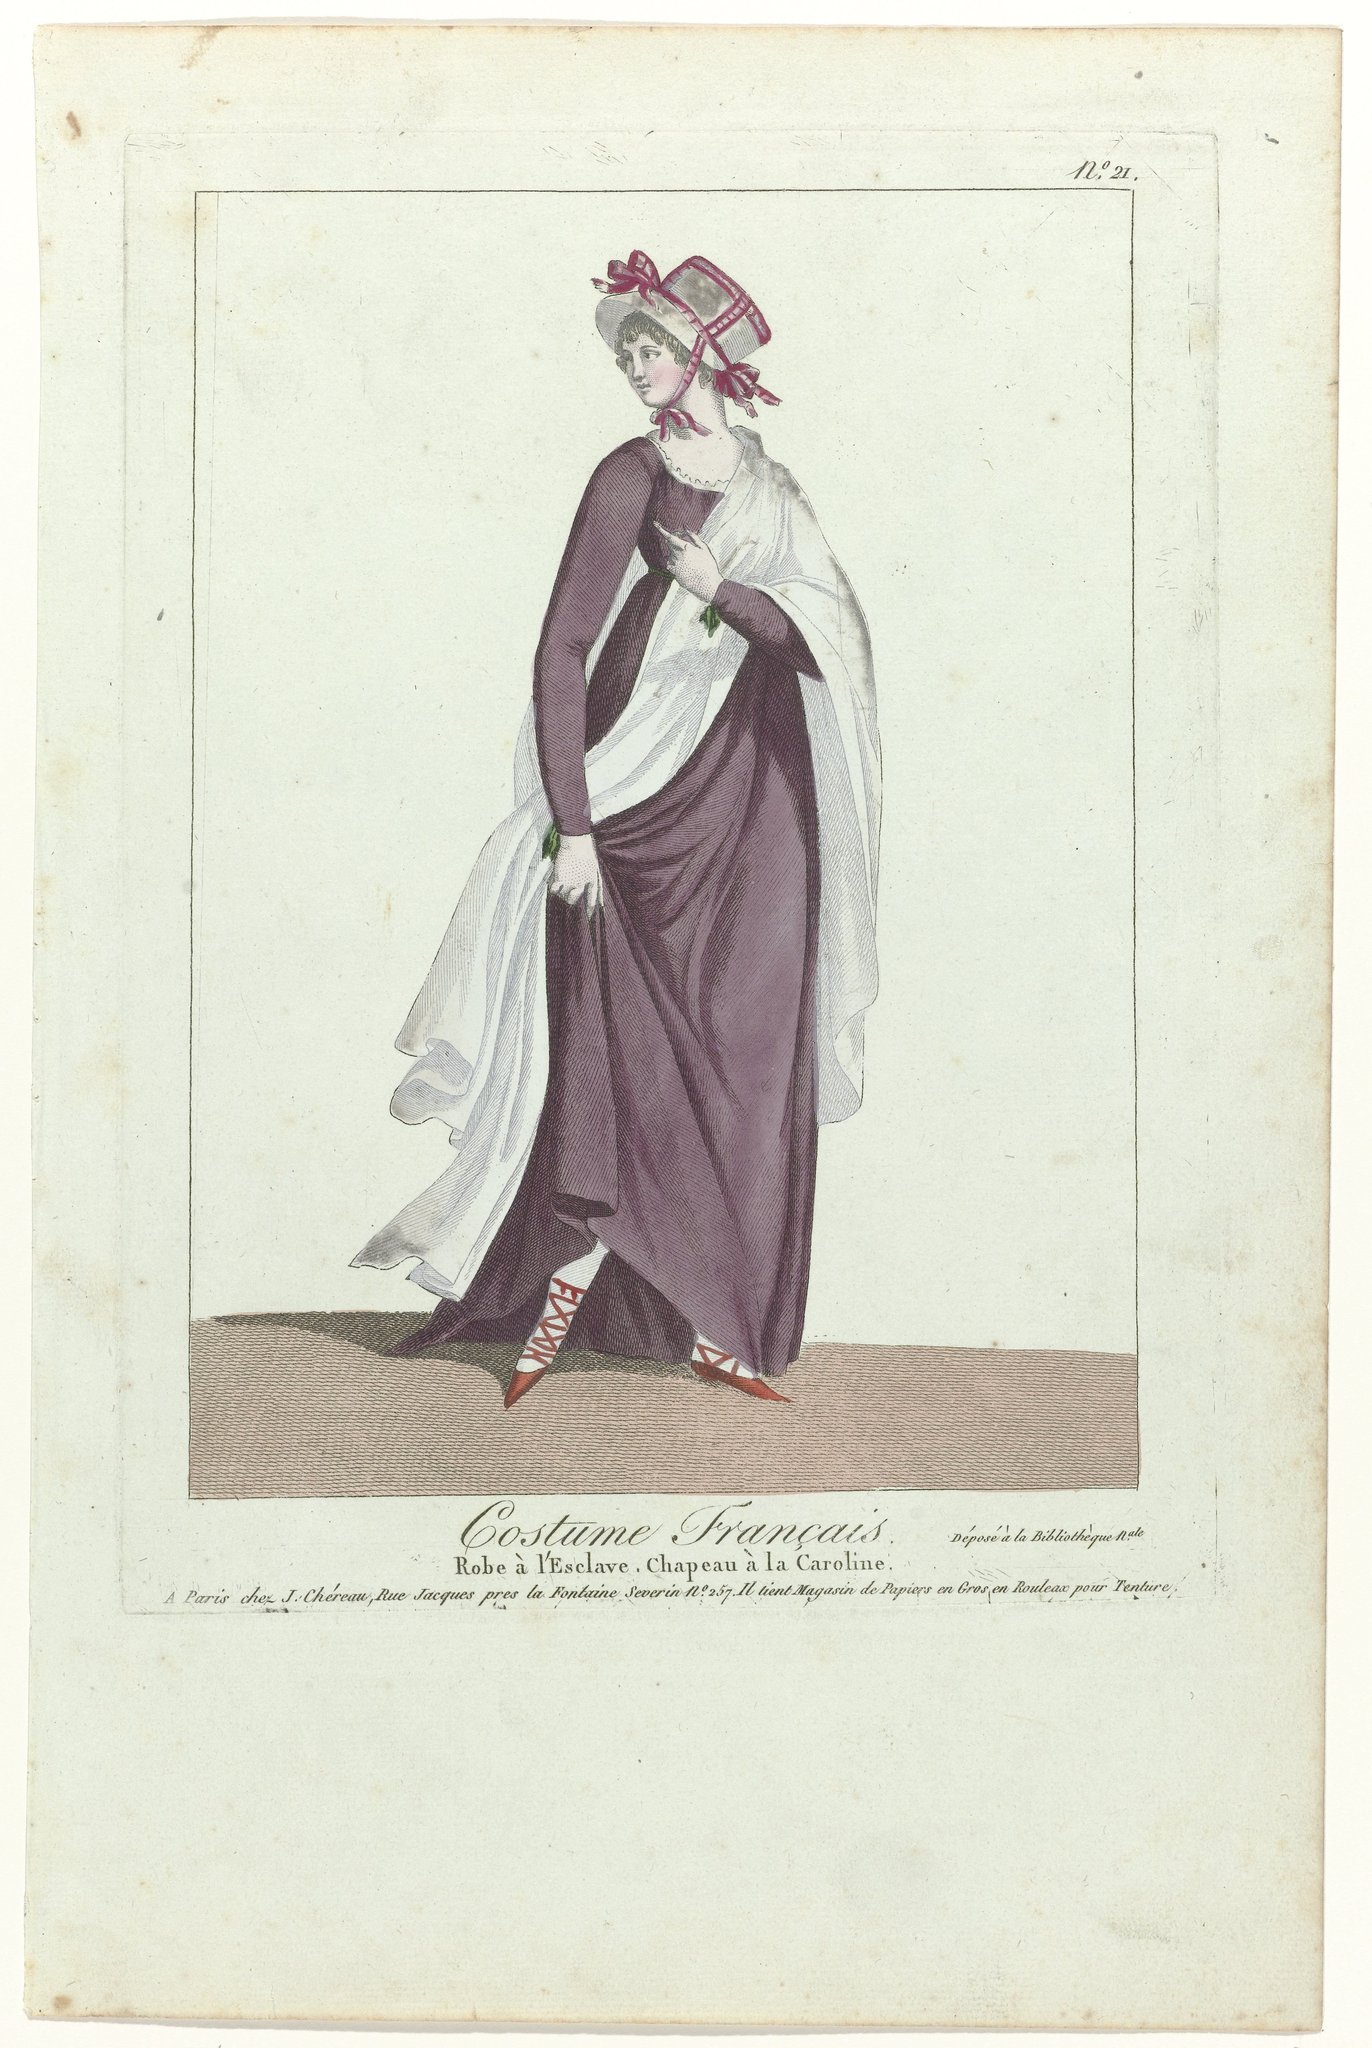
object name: fashion print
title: Costume Français, puis Nouveau Costume Parisien 1799-1810, No. 21: Robe à l'Esclav (...)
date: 1799-1810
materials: paper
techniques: engraving, etching, hand coloring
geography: paris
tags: clothing for the upper part of the body (shawl) (+ women's clothes), fashion plates, head-gear: hat (+ women's clothes), shoes, sandals (+ women's clothes), dress, gown (+ women's clothes)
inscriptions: address: ‘A Paris, chez J. Chéreau. Rue Jacques près la Fontaine Severin, No. 257. Il tient Magasin de Papiers en Gros en Rouleaux pour Tenture.’, caption: ‘Déposé à la Bibliothèque N.ale’, caption: ‘Robe à l'Esclave. Chapeau à la Caroline.’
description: Vrouw, lopend naar rechts, gekleed in een japon met lange mouwen en sleepje: 'Robe à l'Esclave'. Met de rechterhand tilt ze de rok op. Op het hoofd een hoed: 'chapeau à la Caroline'. Verdere accessoires: lange sjaal om de linkerschouder, platte schoenen met puntige neuzen en gekruiste banden. De prent maakt deel uit van een serie van 142 modeprenten, waarvan er 115 zijn geïdentificeerd, uitgegeven door J. Chéreau, Parijs, 1799-1810.